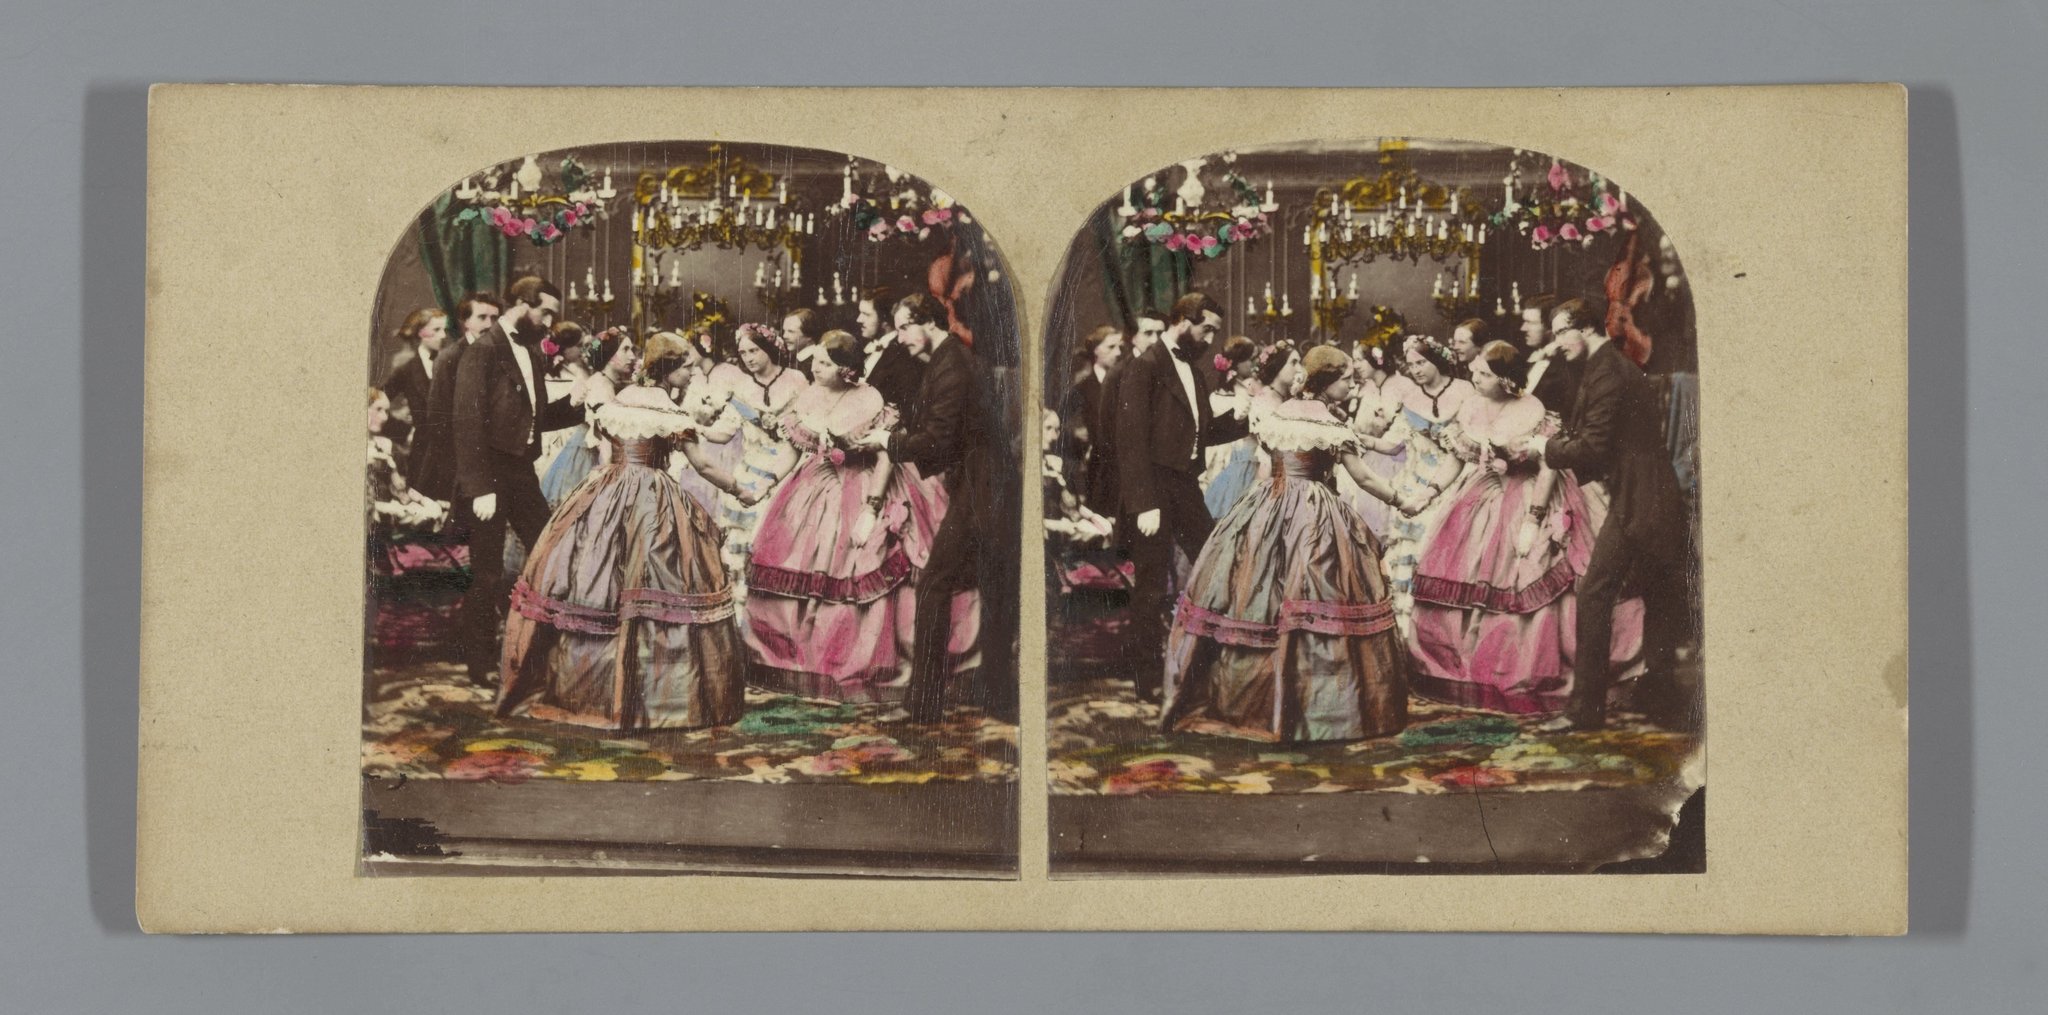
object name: stereograph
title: Salonscène: dansende paren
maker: Anonymous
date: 1852-1863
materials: cardboard, paper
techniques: albumen print, hand coloring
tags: ball, formal dance